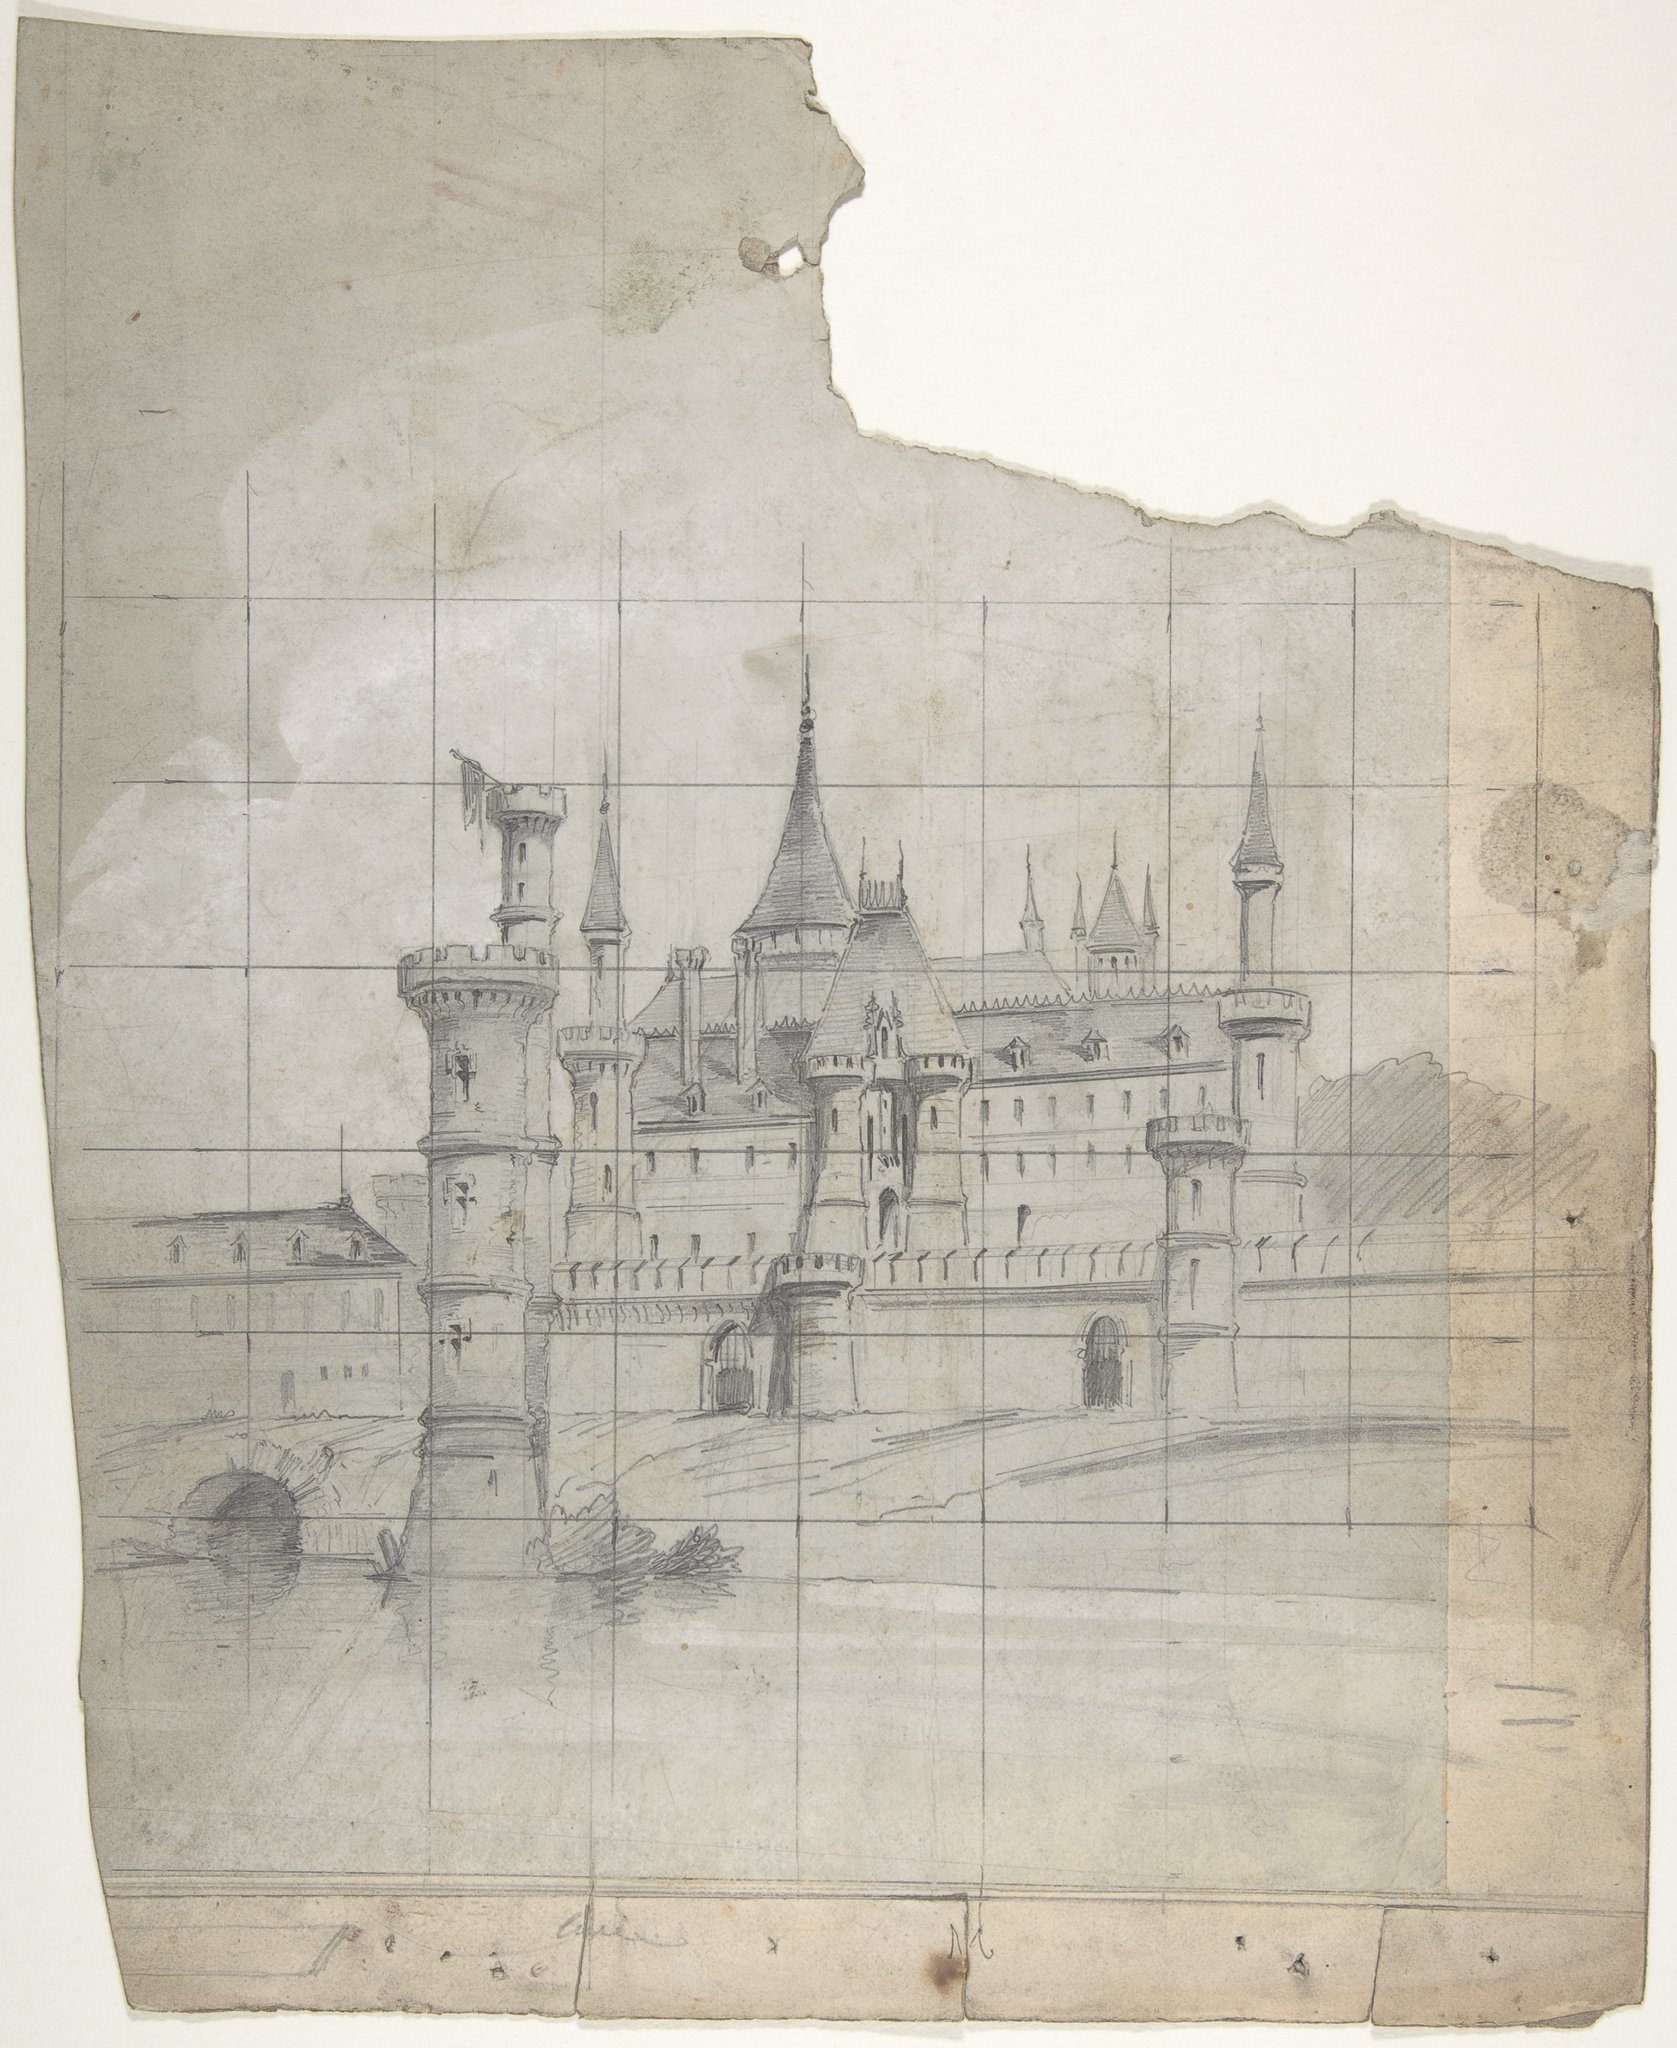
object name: drawing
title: Design for a Stage Set at the Opéra, Paris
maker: eugène cicéri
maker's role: artist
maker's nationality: french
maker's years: 1813-1890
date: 1830-1890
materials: graphite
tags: castles,stage design